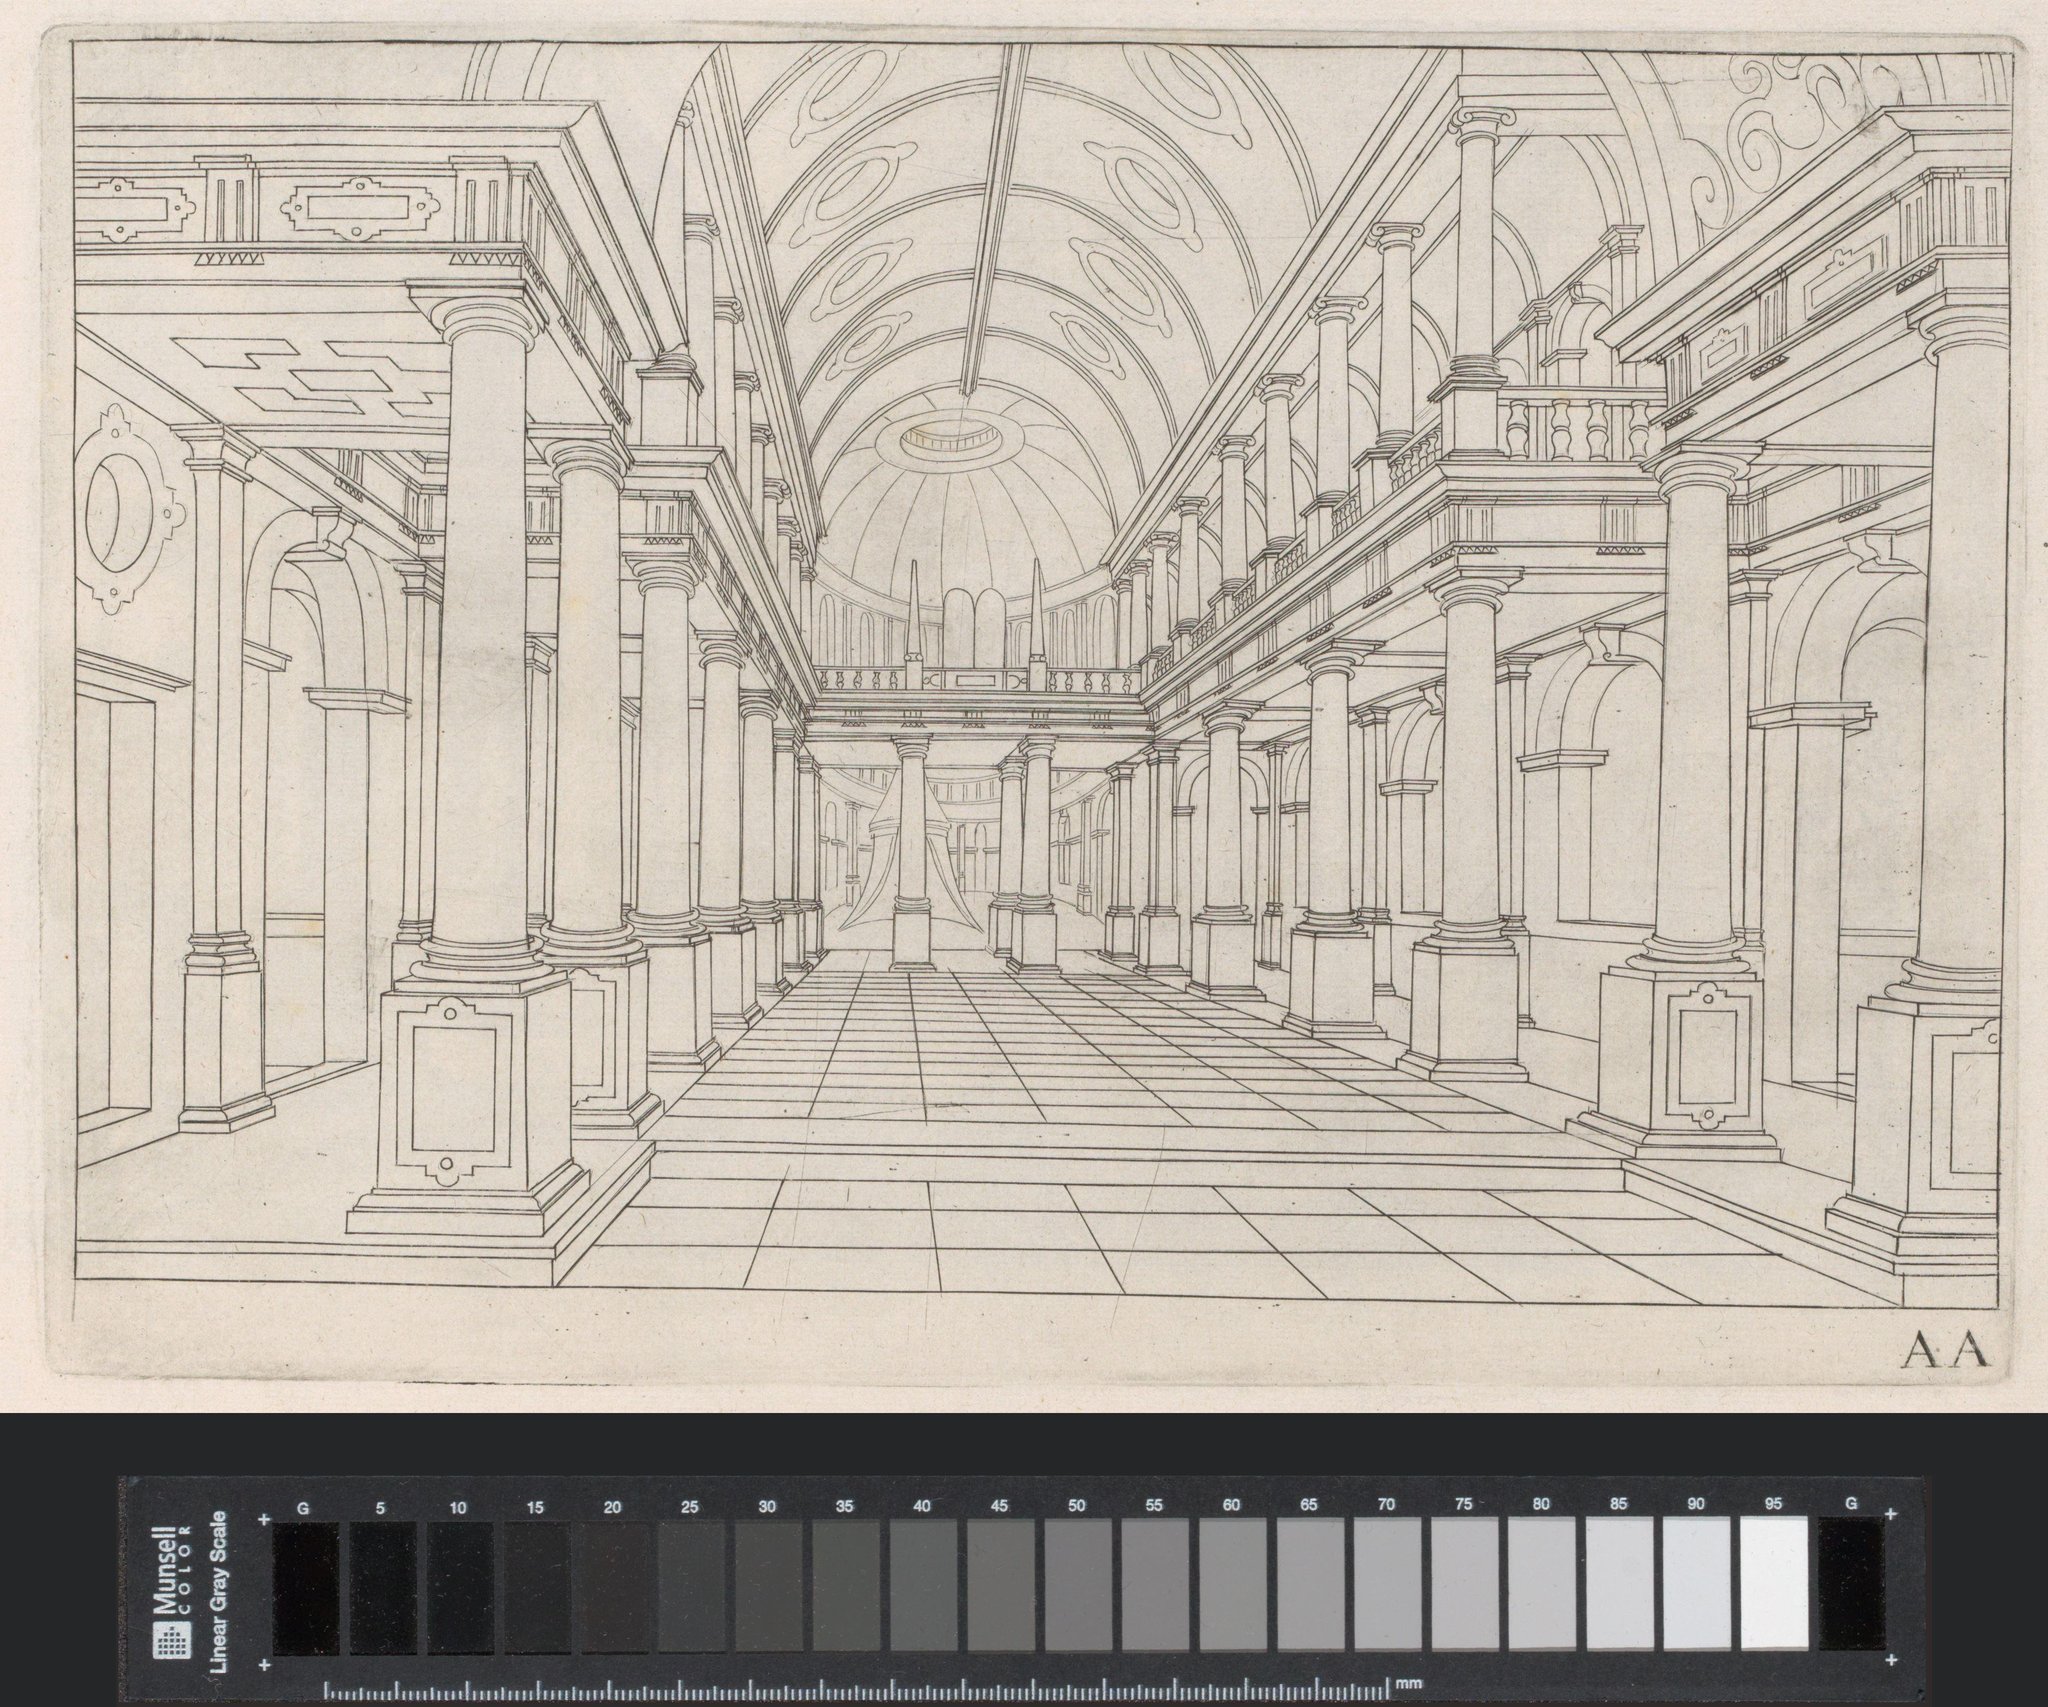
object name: album leaf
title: Interieur van een kerk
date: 1606-1607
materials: paper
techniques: engraving, etching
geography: the hague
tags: tuscan order ~ architecture, interior of church, ionic order ~ architecture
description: Interieur van een kerk met zuilen van de Toscaanse en Ionische orde. In het koor een baldakijn. Rechtsonder: AA. Prent maakt deel uit van een album.